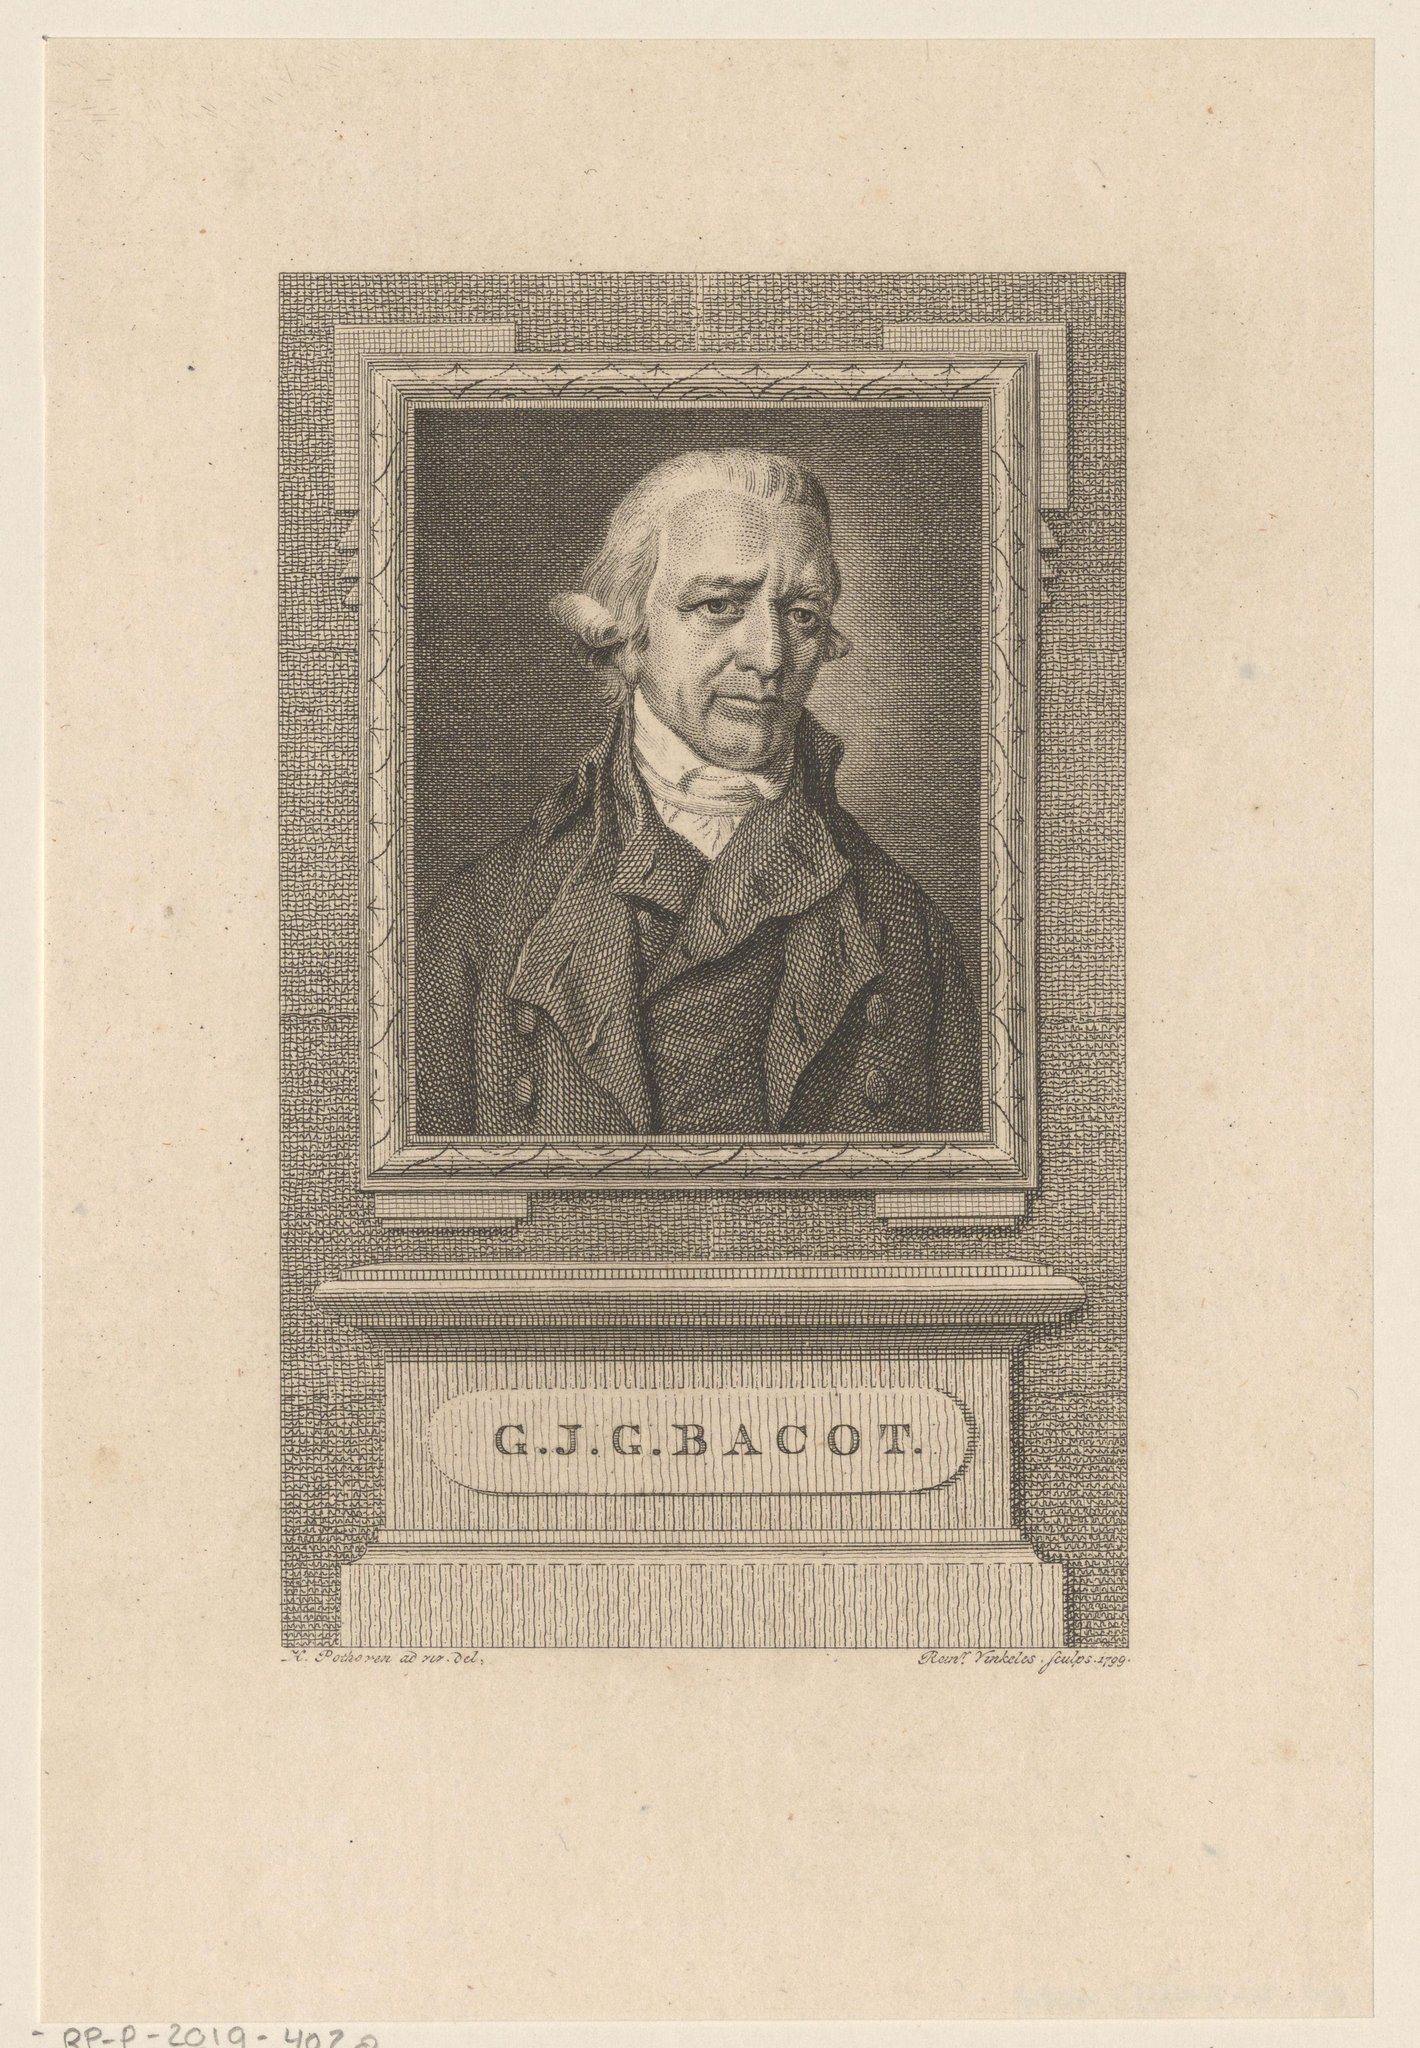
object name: print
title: Portret van Gerard Jacob Georg Bacot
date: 1799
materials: paper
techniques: engraving, etching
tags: the hague, historical persons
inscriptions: date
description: Prent uit: Wagenaar, Jan. Vaderlandsche historie, (...). Amsterdam: Johannes Allart, 1786-1809. dl. 22.